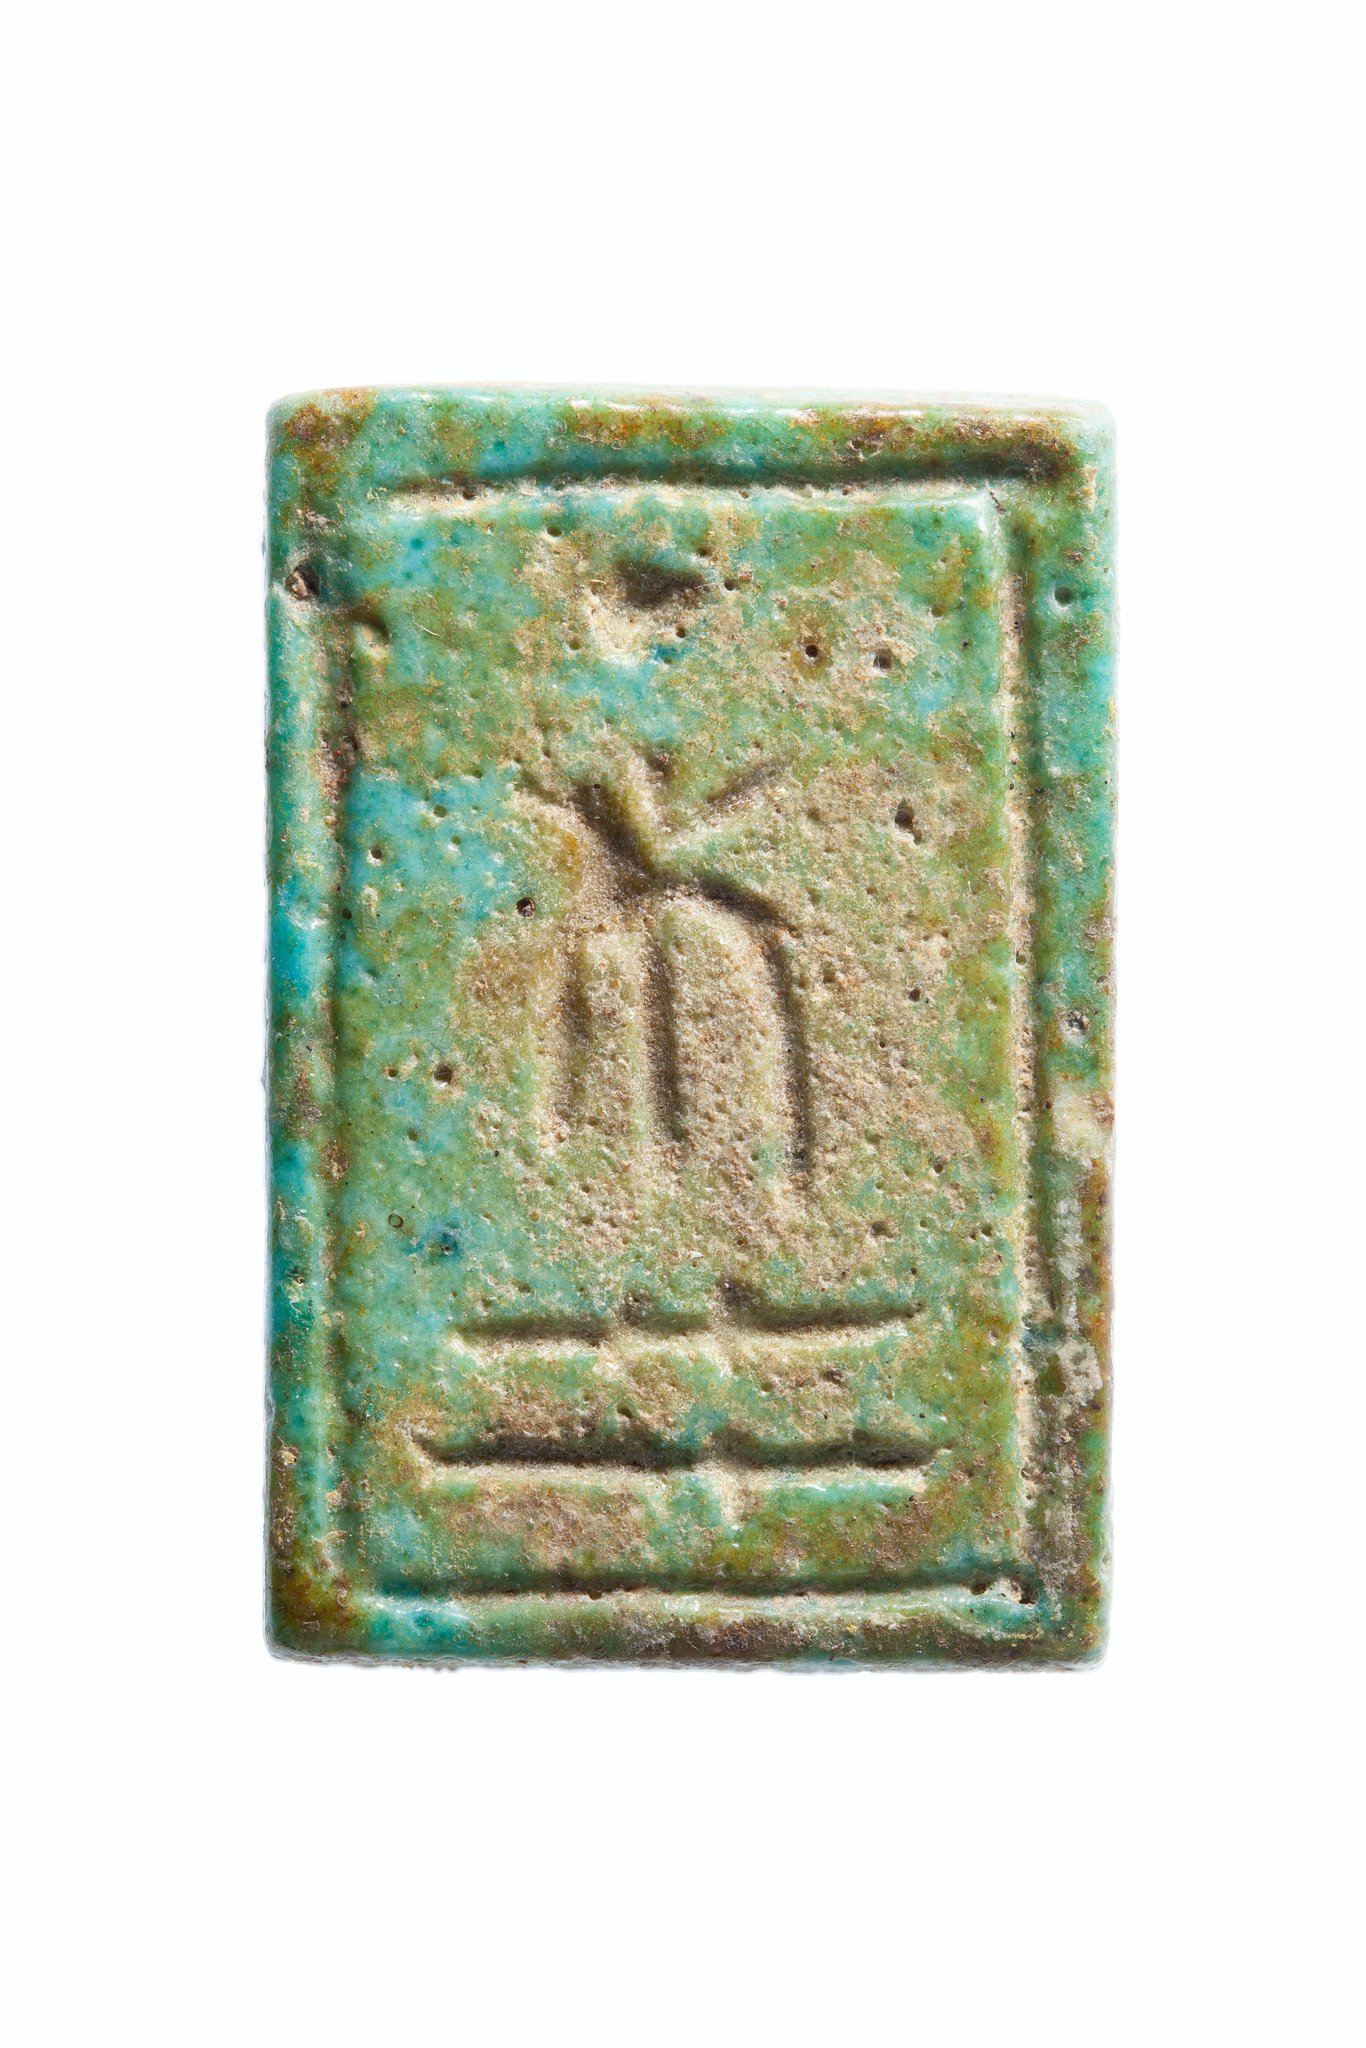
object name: foundation deposit plaque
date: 1200-1085 BCE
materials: faience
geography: egypt